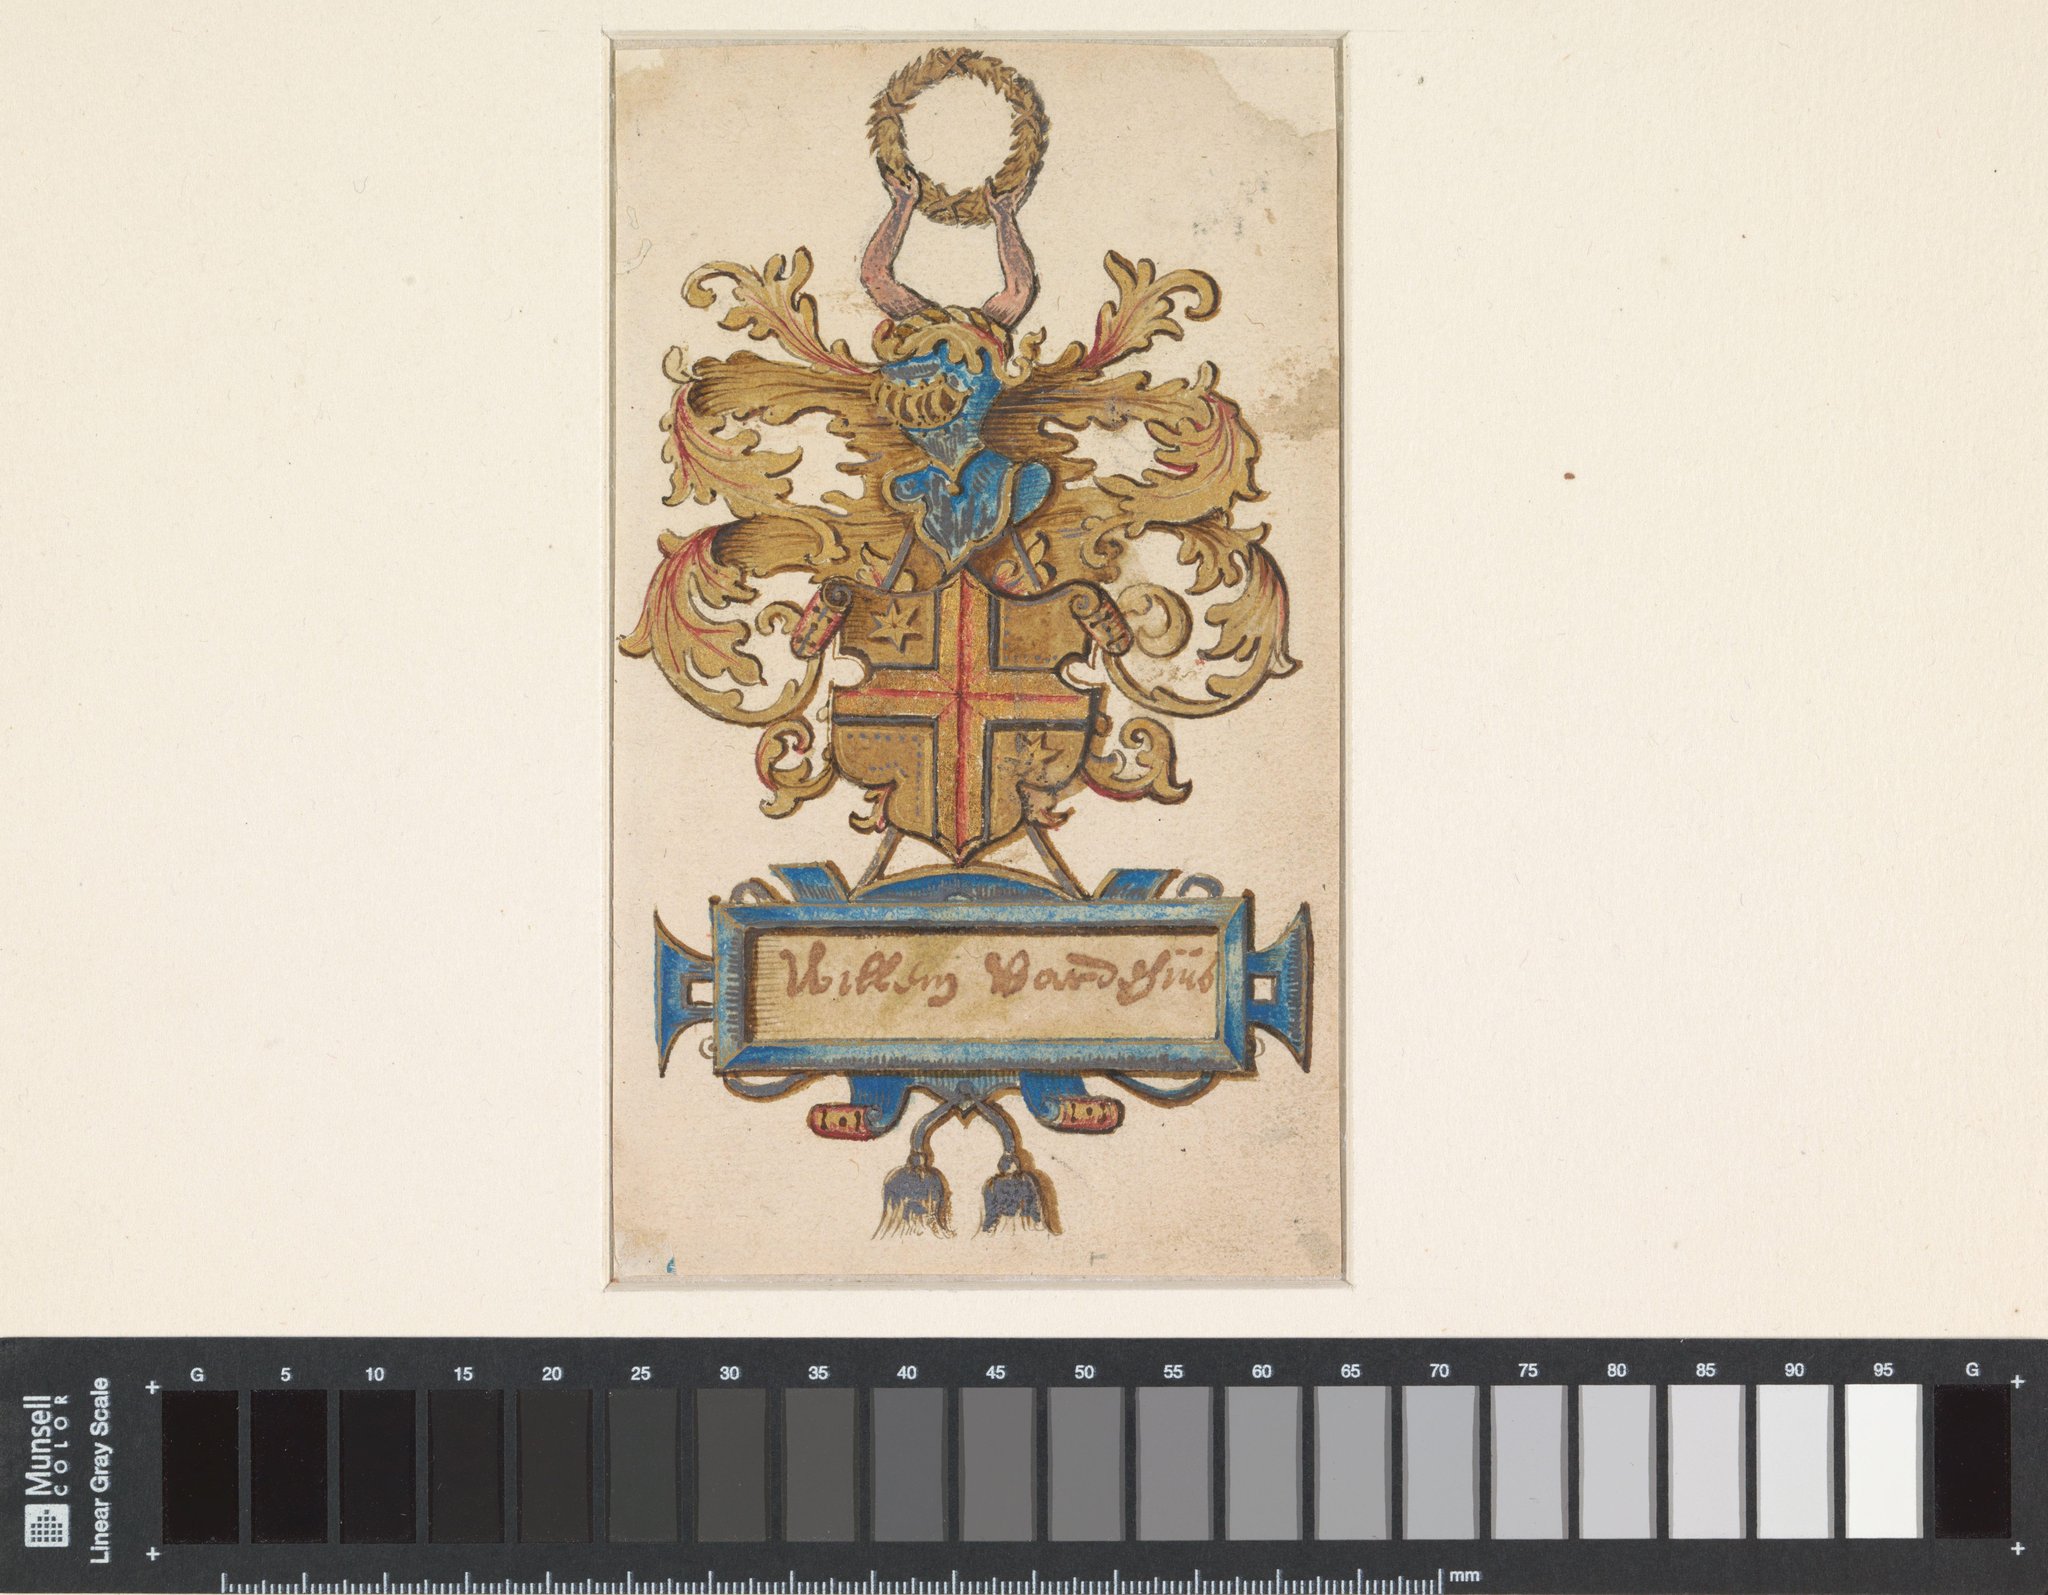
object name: drawing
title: Wapen van Willem Bardes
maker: Anonymous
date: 1600-1649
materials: paint, ink, paper, watercolor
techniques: brush, pen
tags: mayor, armorial bearing, heraldry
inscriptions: inscription: ‘Willem Bardesius’